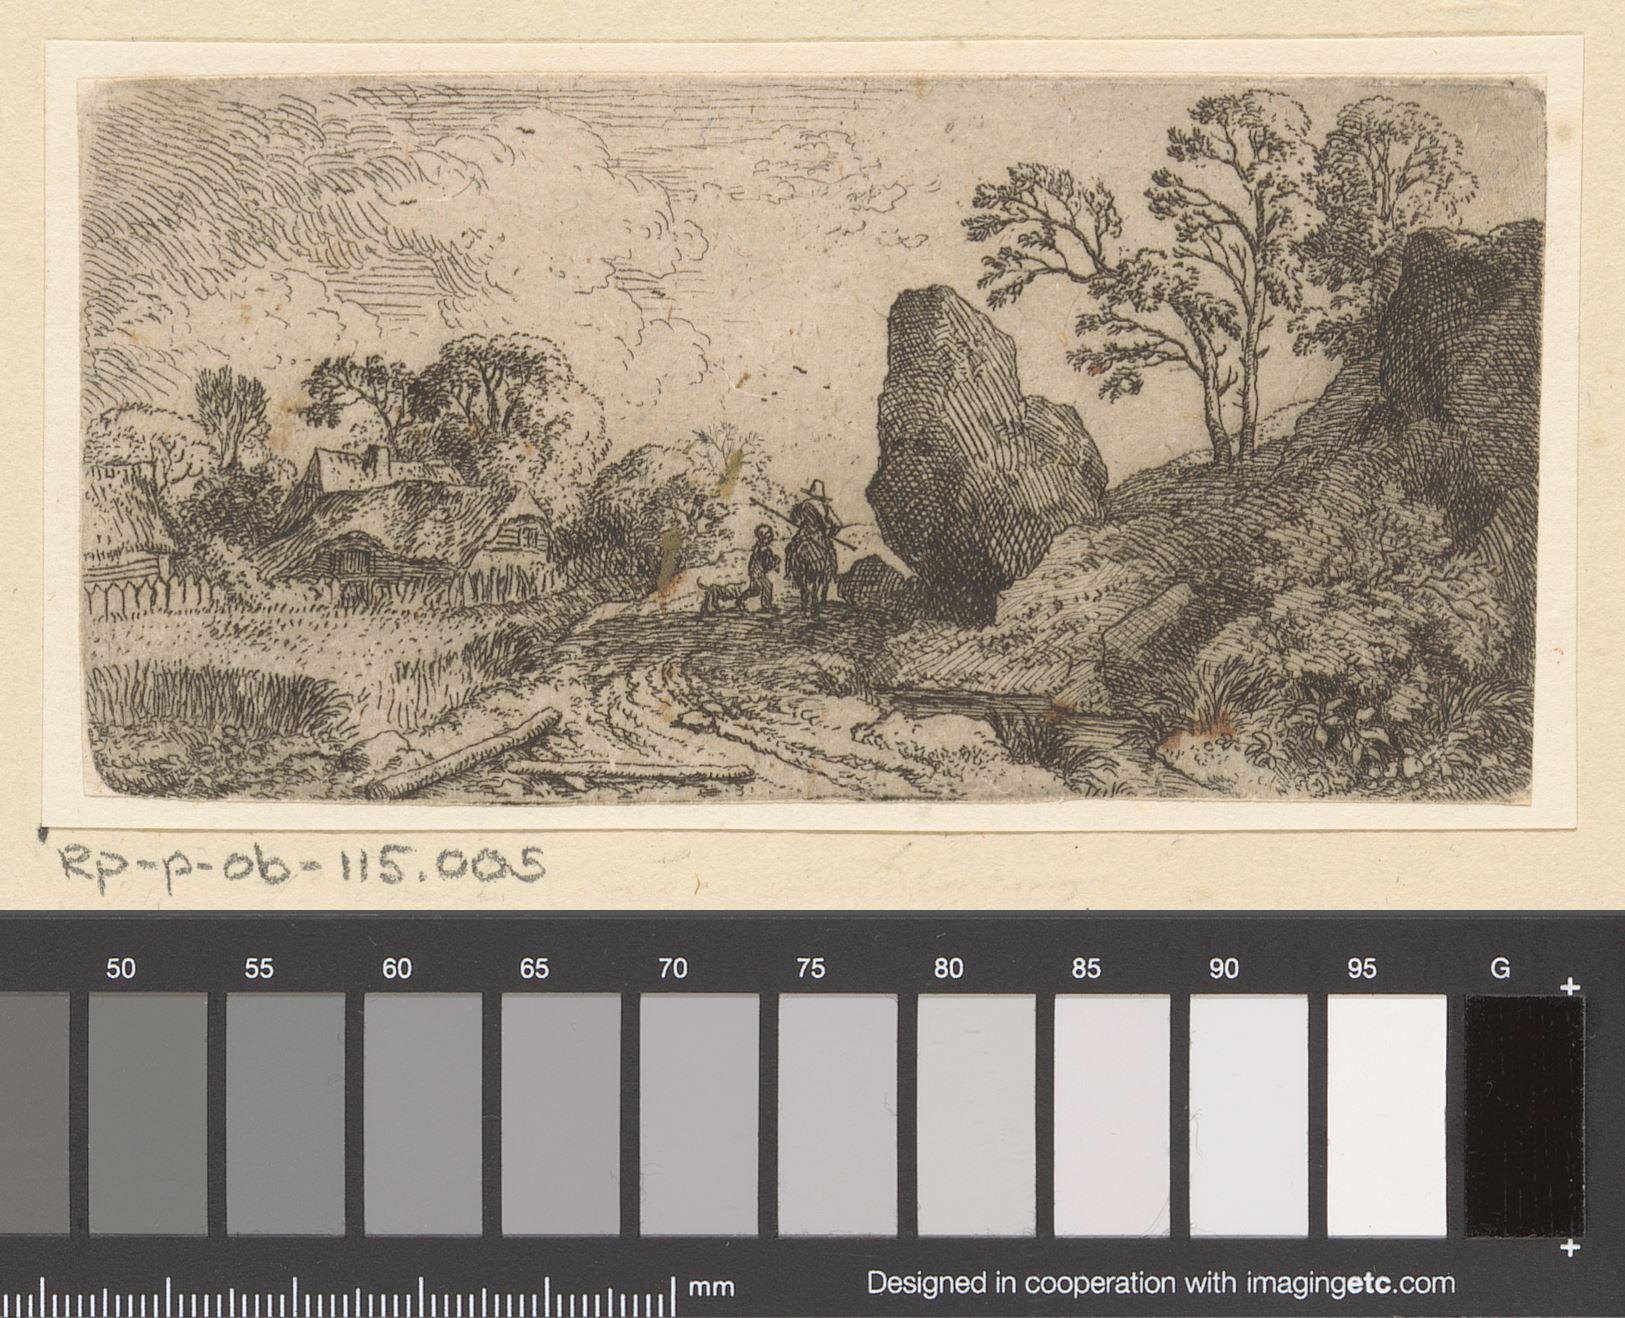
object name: print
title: Landschap met rotsblok rechts van de weg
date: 1722-1774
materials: paper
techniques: etching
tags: city-view, and landscape with man-made constructions, road, path, boulder, stone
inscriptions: collector's mark: Lugt 240